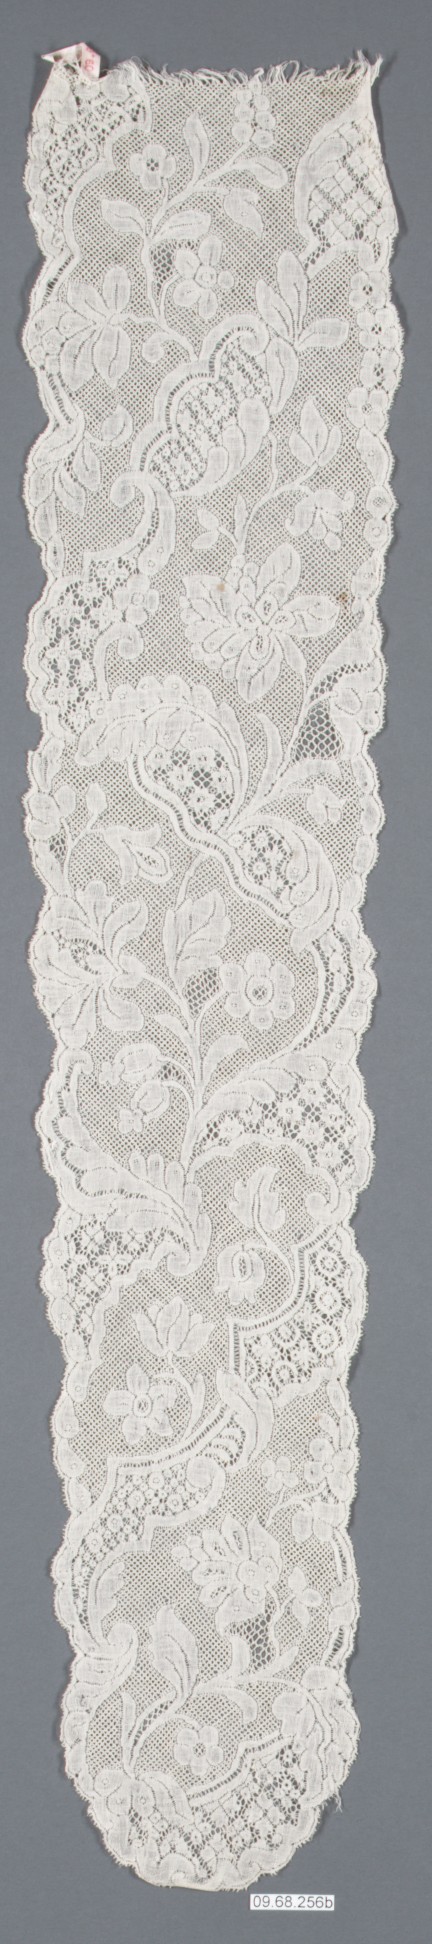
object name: lappet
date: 1700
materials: linen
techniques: lace